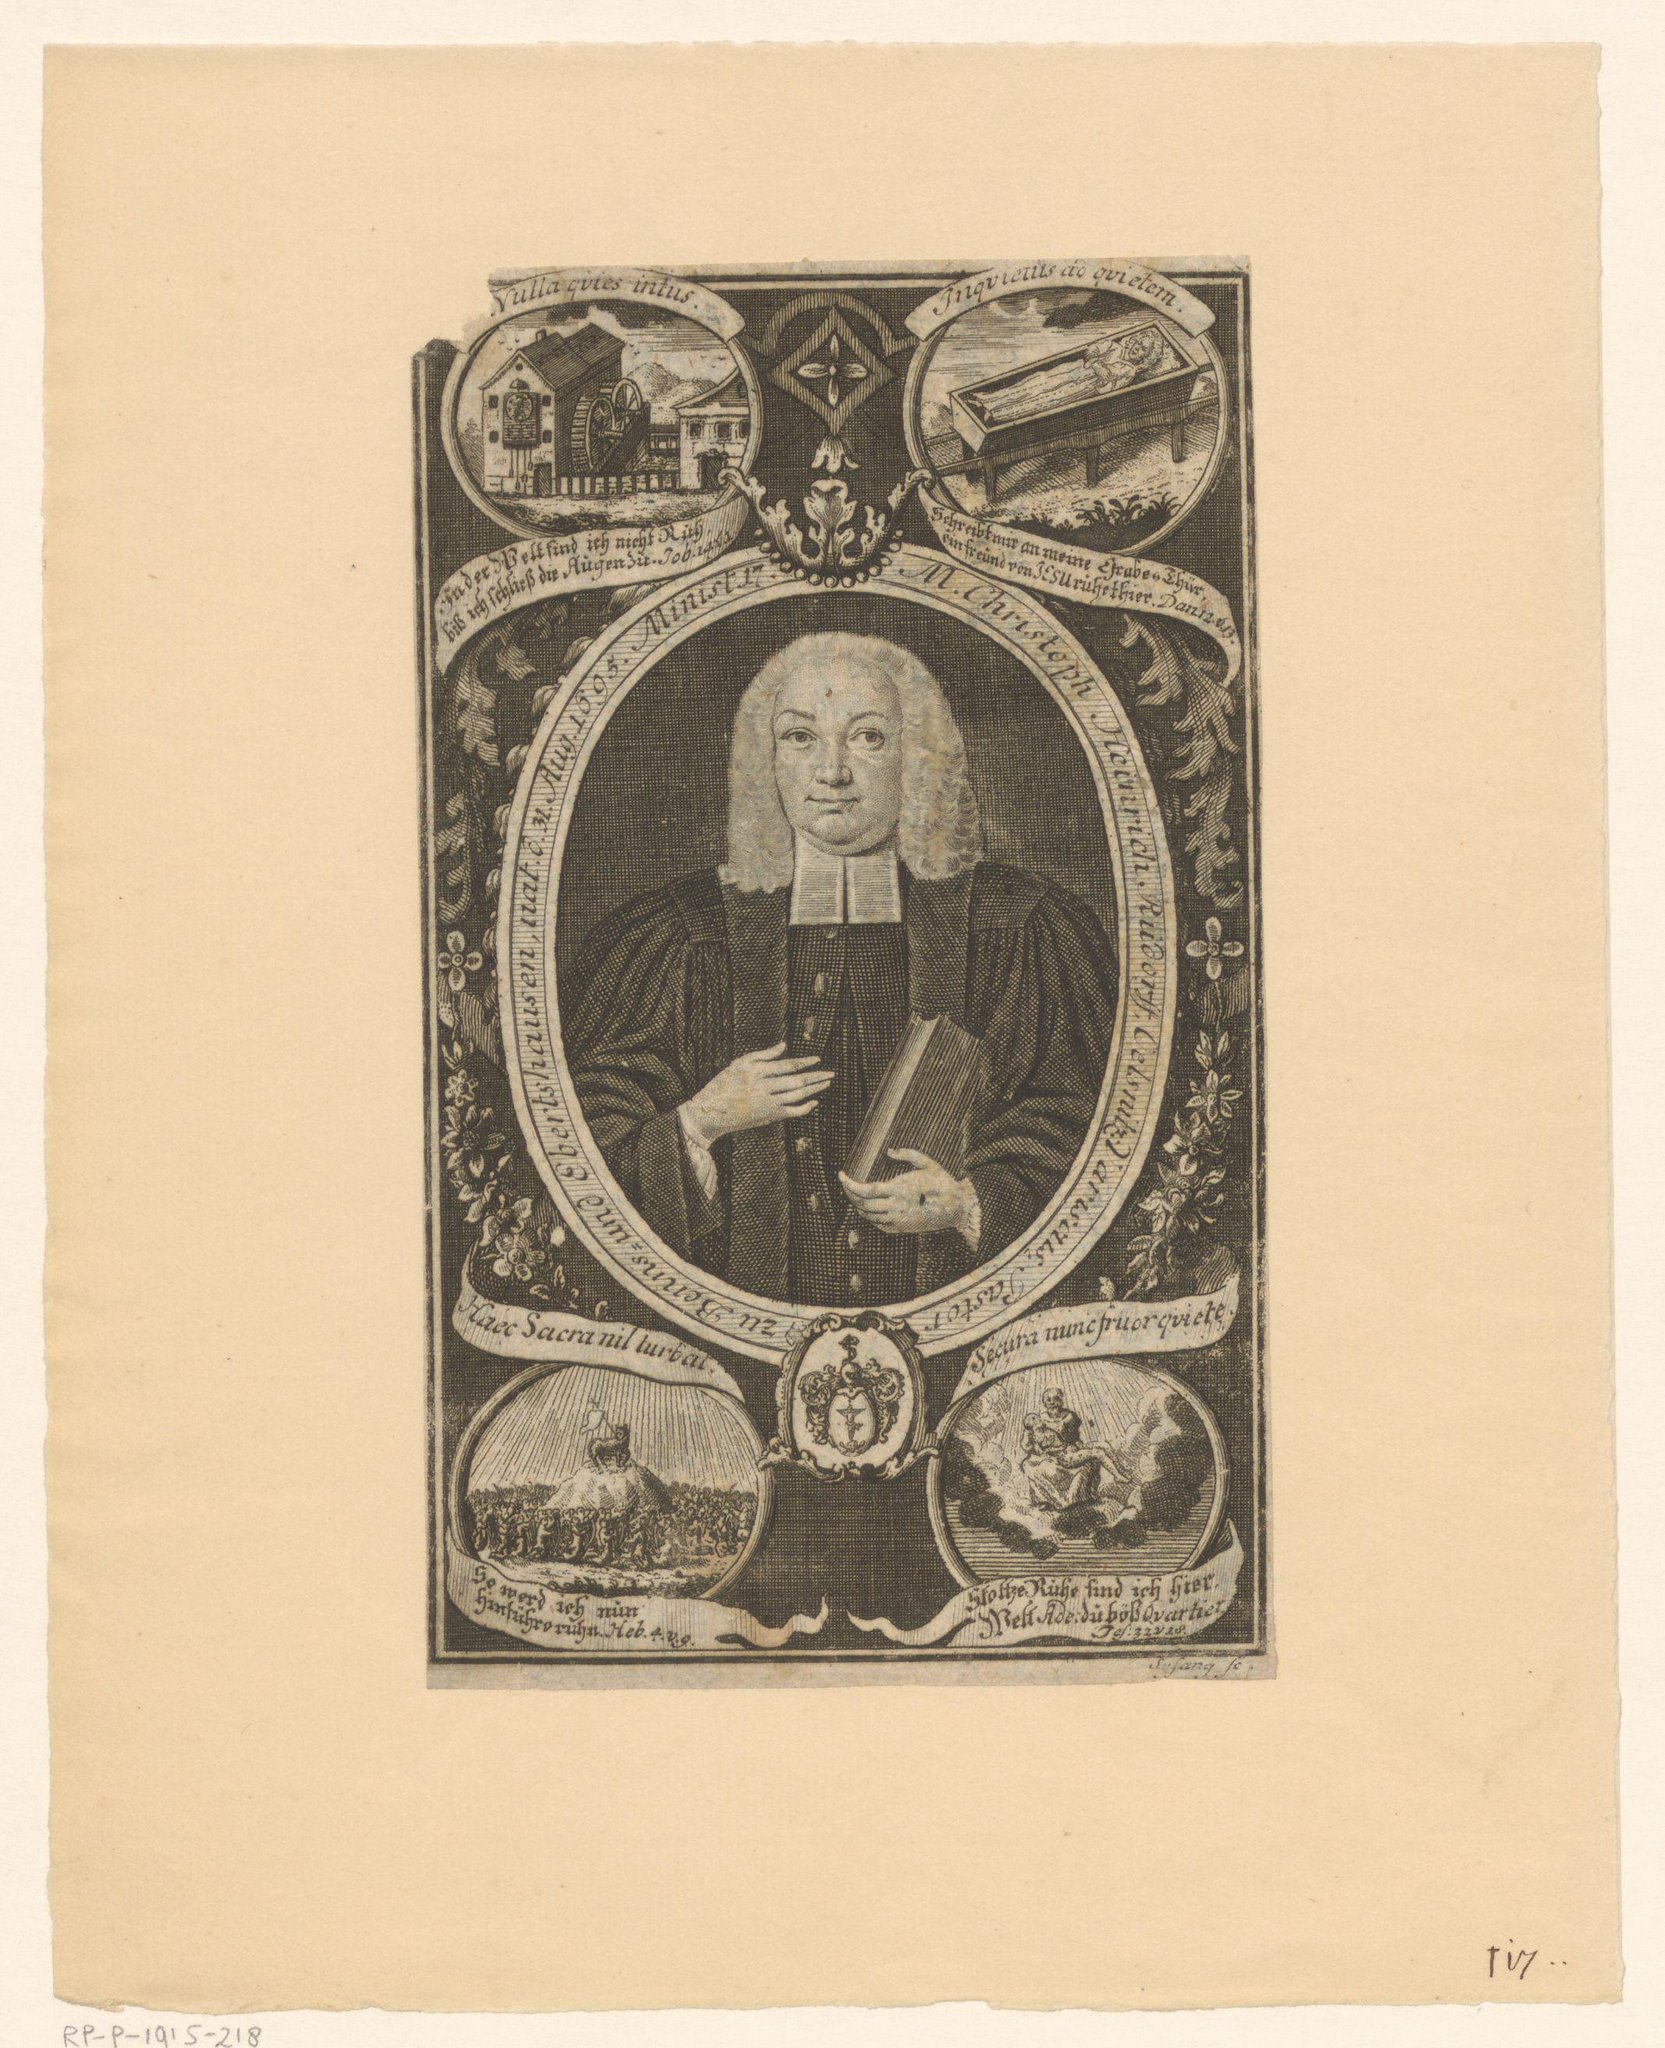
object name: print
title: Portret van Christoph Heinrich Rudorff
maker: johann christoph sysang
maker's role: print maker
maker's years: 1703-1757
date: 1730-1757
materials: paper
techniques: engraving, etching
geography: germany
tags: historical persons, book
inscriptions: collector's mark: Lugt 2228